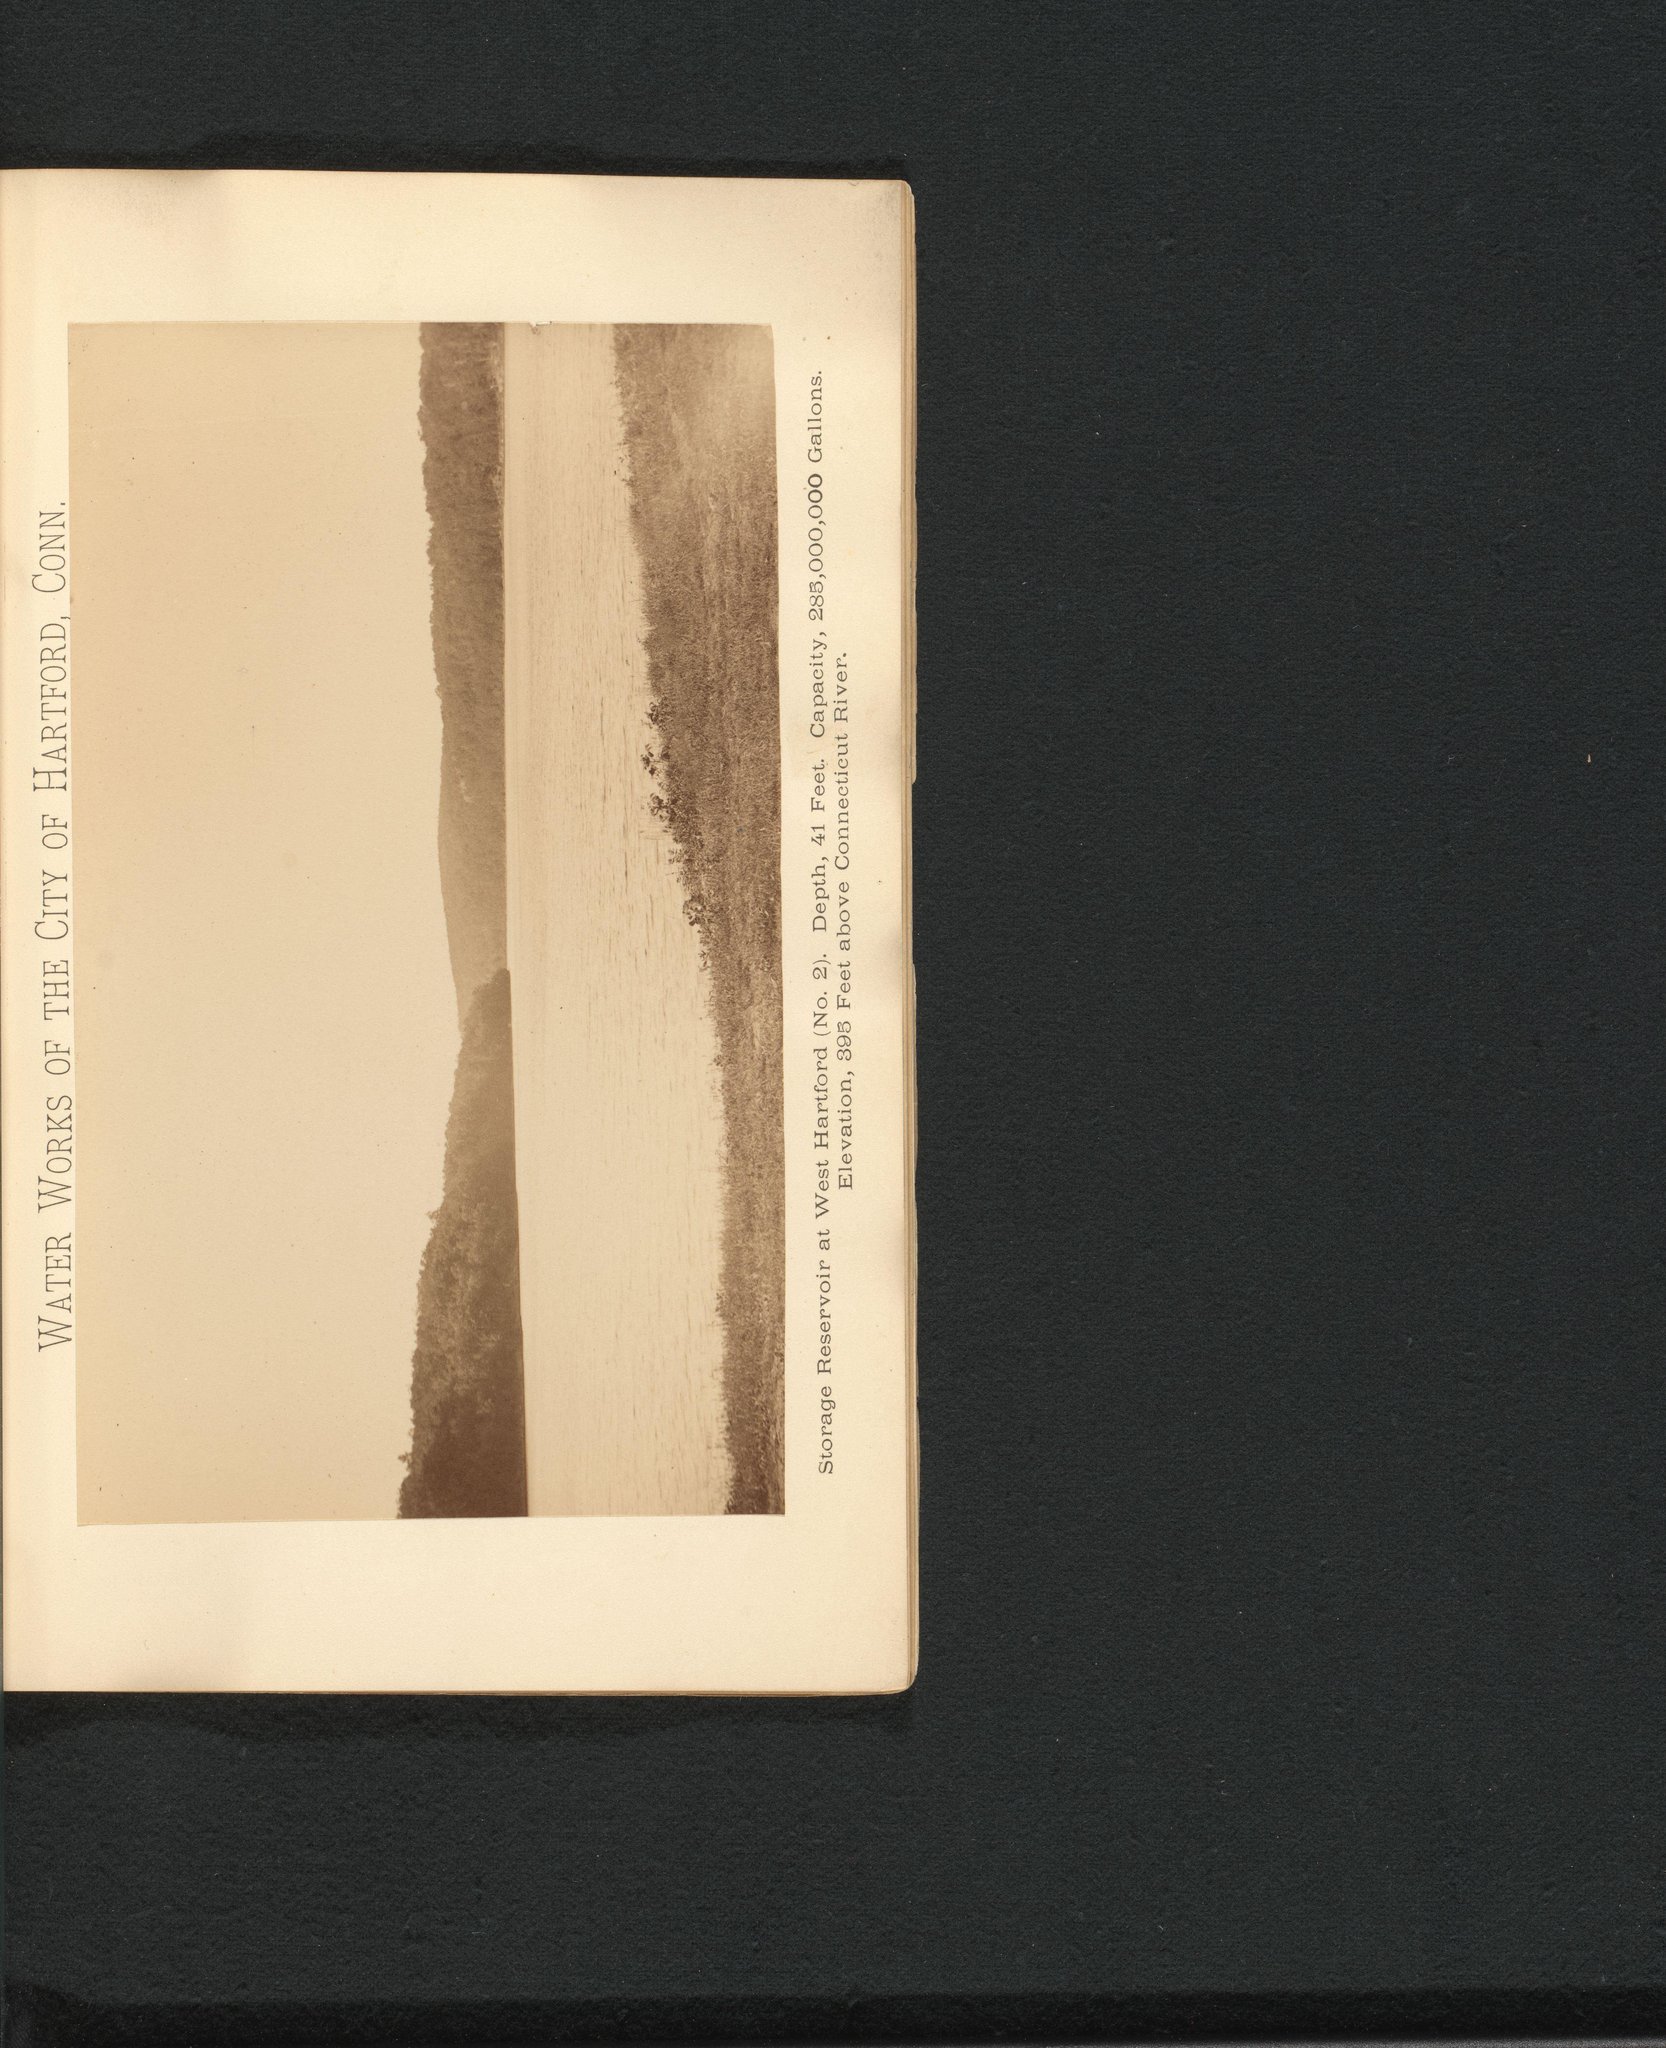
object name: photograph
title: Storage reservoir at West Hartford (no. 2). Depth, 41 feet. Capacity 285,000,000 gallons. Elevation, 395 feet above Connecticut river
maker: Anonymous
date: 1883-1884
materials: photographic support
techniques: albumen print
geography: connecticut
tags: water course